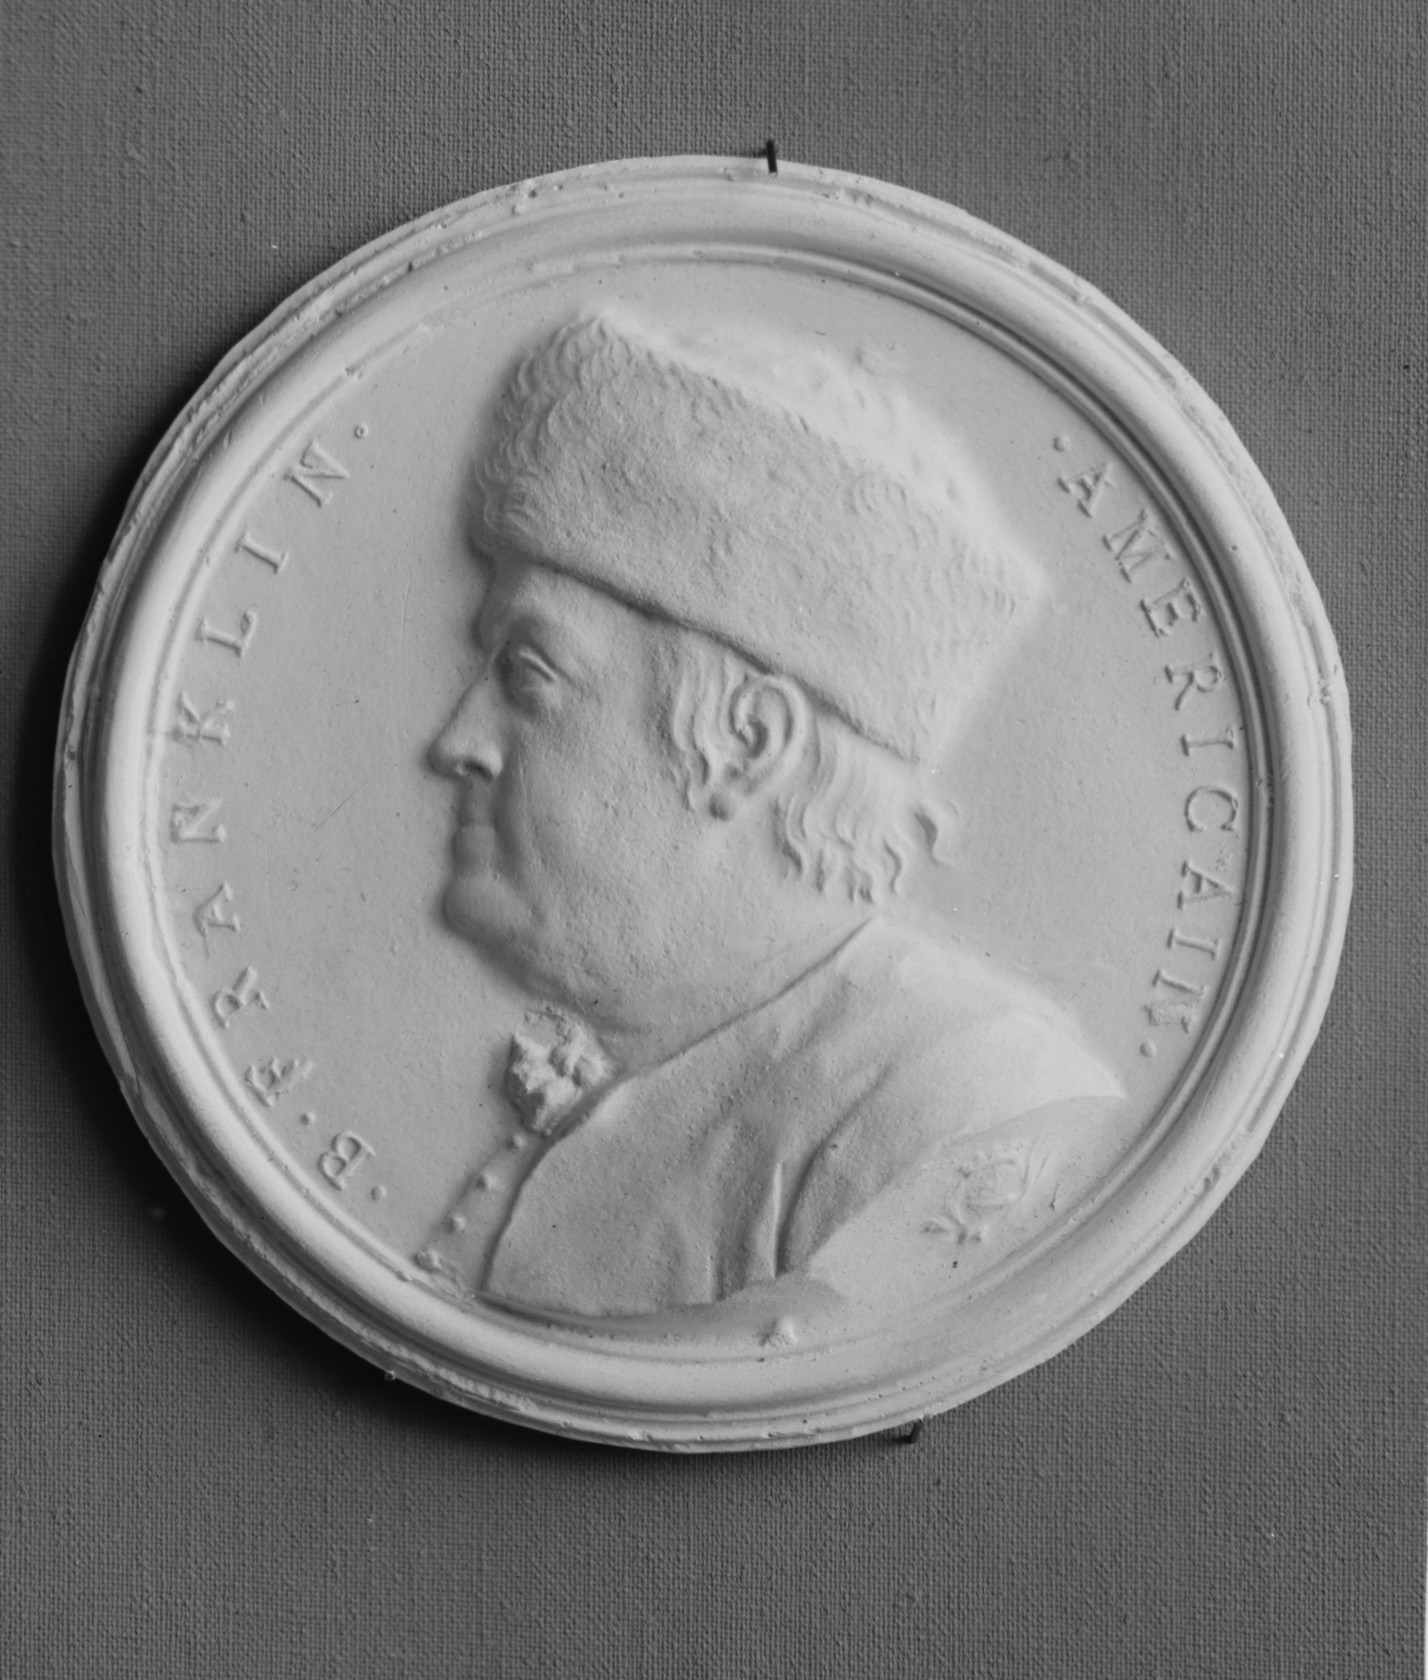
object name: medallion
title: Benjamin Franklin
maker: jean-baptiste nini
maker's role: artist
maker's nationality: italian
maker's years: 1717-1786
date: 1701-1800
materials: plaster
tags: benjamin franklin,profiles